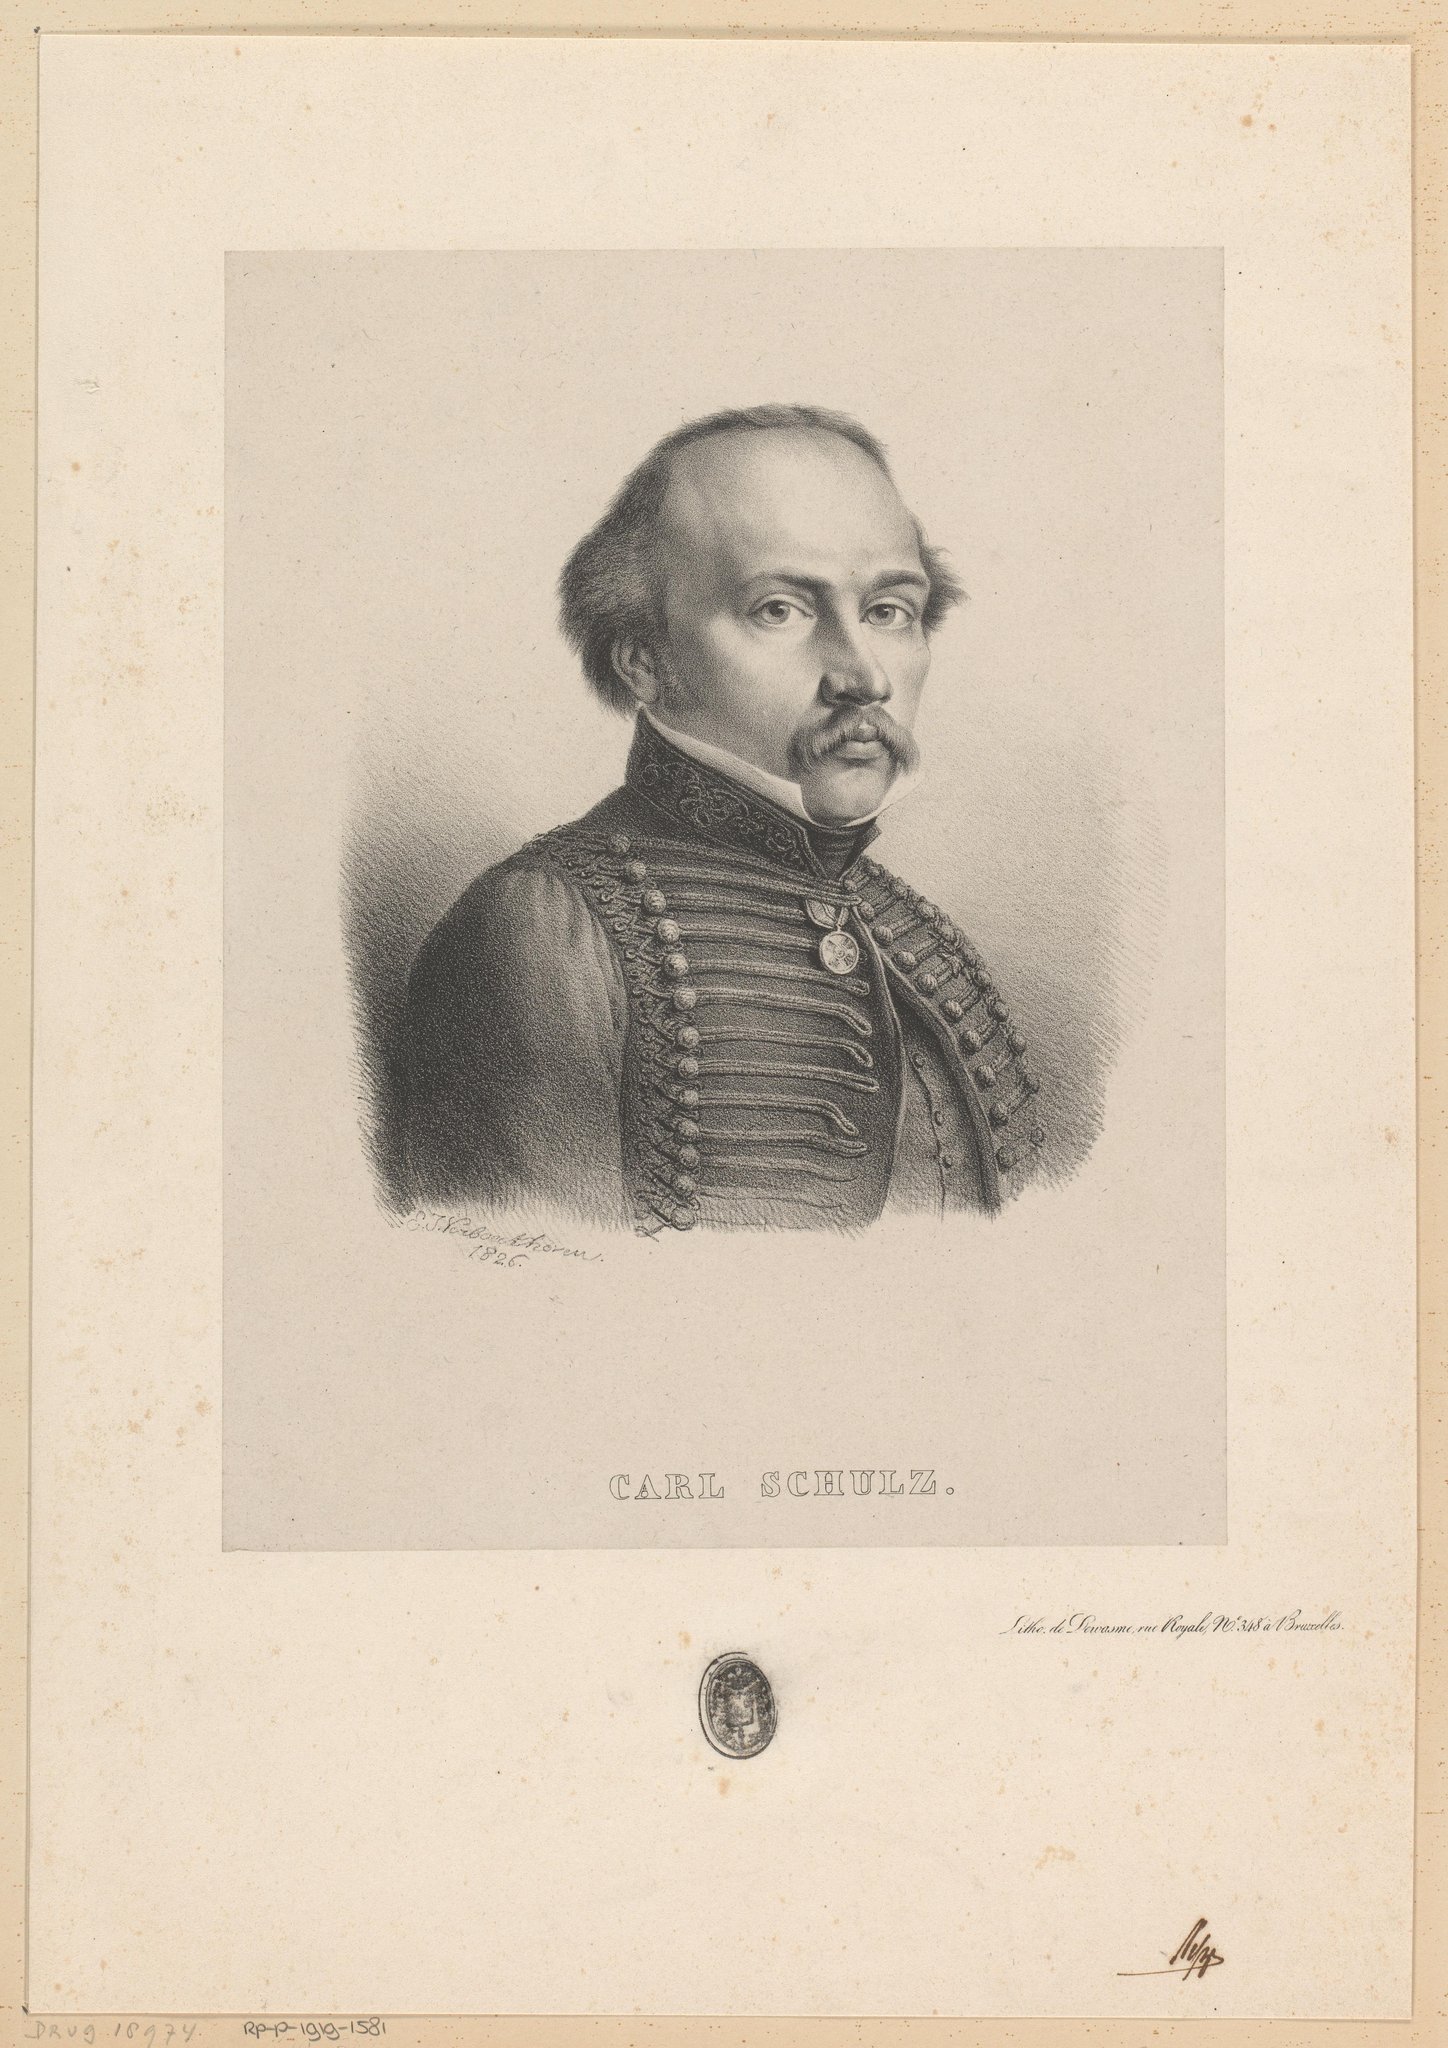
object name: print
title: Carl Schulz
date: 1826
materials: paper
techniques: lithograph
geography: brussels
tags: painter, historical persons, portrait, self-portrait of artist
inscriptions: stamp:, inscription: ‘[...]’, collector's mark: Lugt 2228